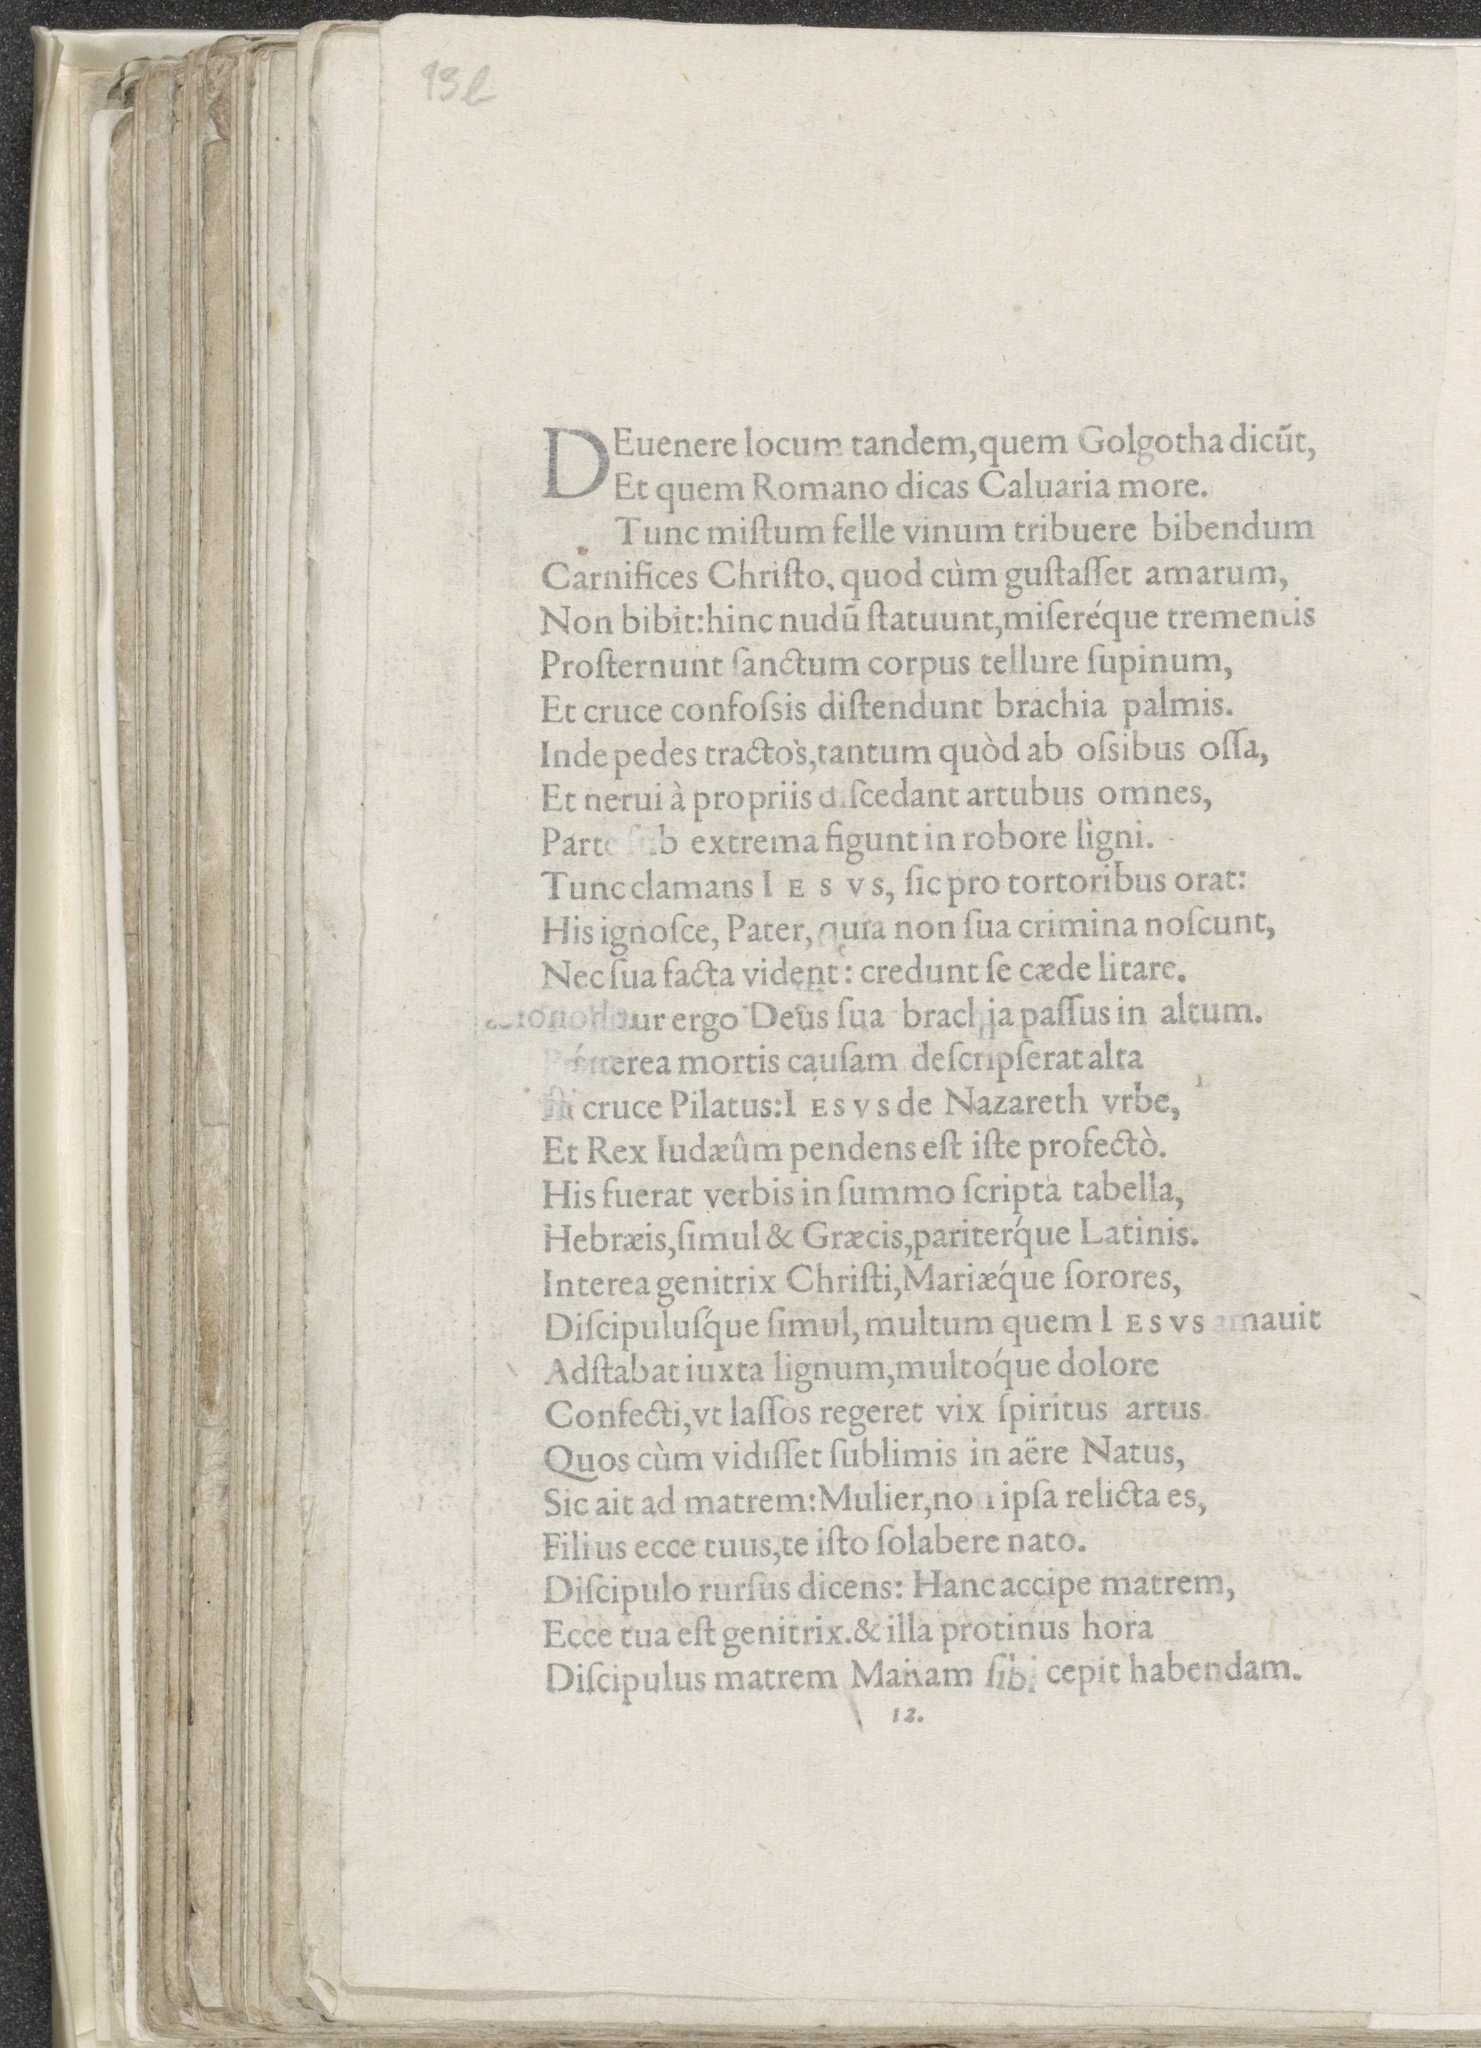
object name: text sheet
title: Passie van Christus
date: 1572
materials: paper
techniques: letterpress printing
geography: antwerp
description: Tijdens de restauratie in 1988 bleek dat op de achterzijde van de prenten van de Passie-serie van Wierix Latijnse teksten in boekdruk staan. Deze vormen, wanneer op de juiste wijze in boekvorm gebonden (wat nu in het Heemskerck-album niet het geval is), een toelichting op de passievoorstellingen. Om de teksten zichtbaar te laten zijn de prenten bij de restauratie niet meer met de achterzijde op elkaar geplakt.